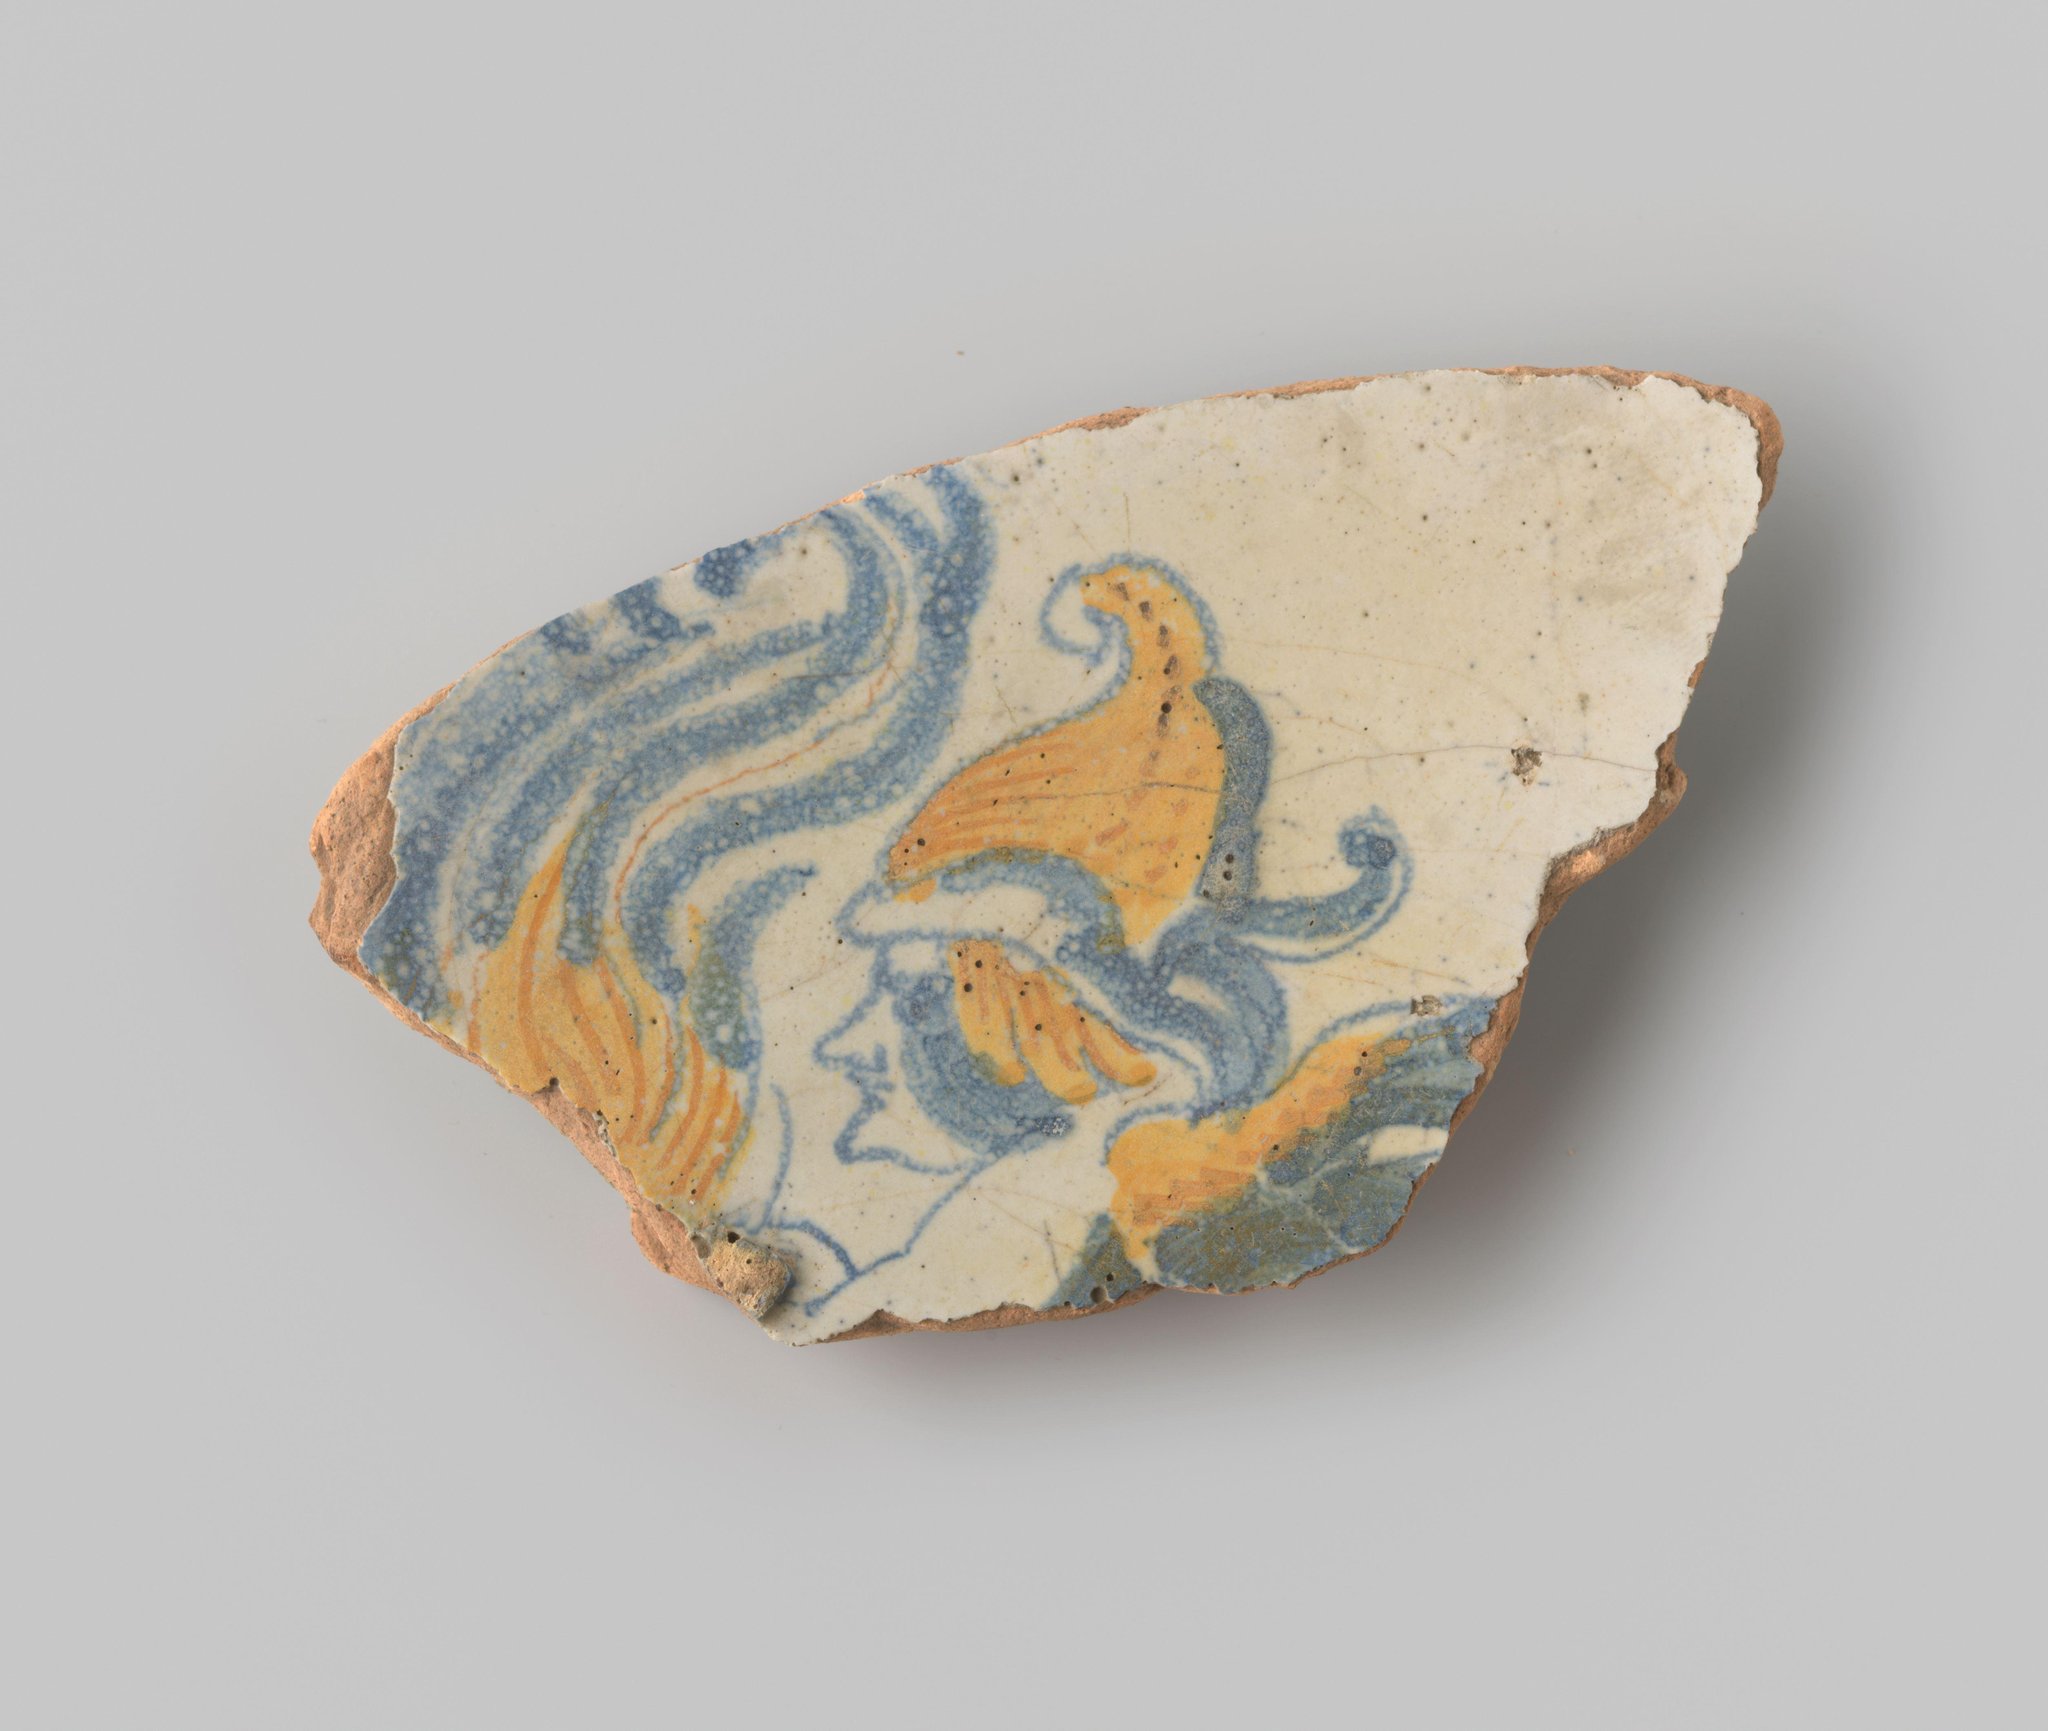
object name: sherd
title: Schotelscherf van roodbakkend aardewerk, voorzien van wit glazuur, waarop een schildering in blauw, geel en oranje, van een persoon met muts en profil, met daarnaast mogelijk een vlam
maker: Anonymous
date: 1600-1650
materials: earthenware, glaze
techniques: maiolica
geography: northern netherlands